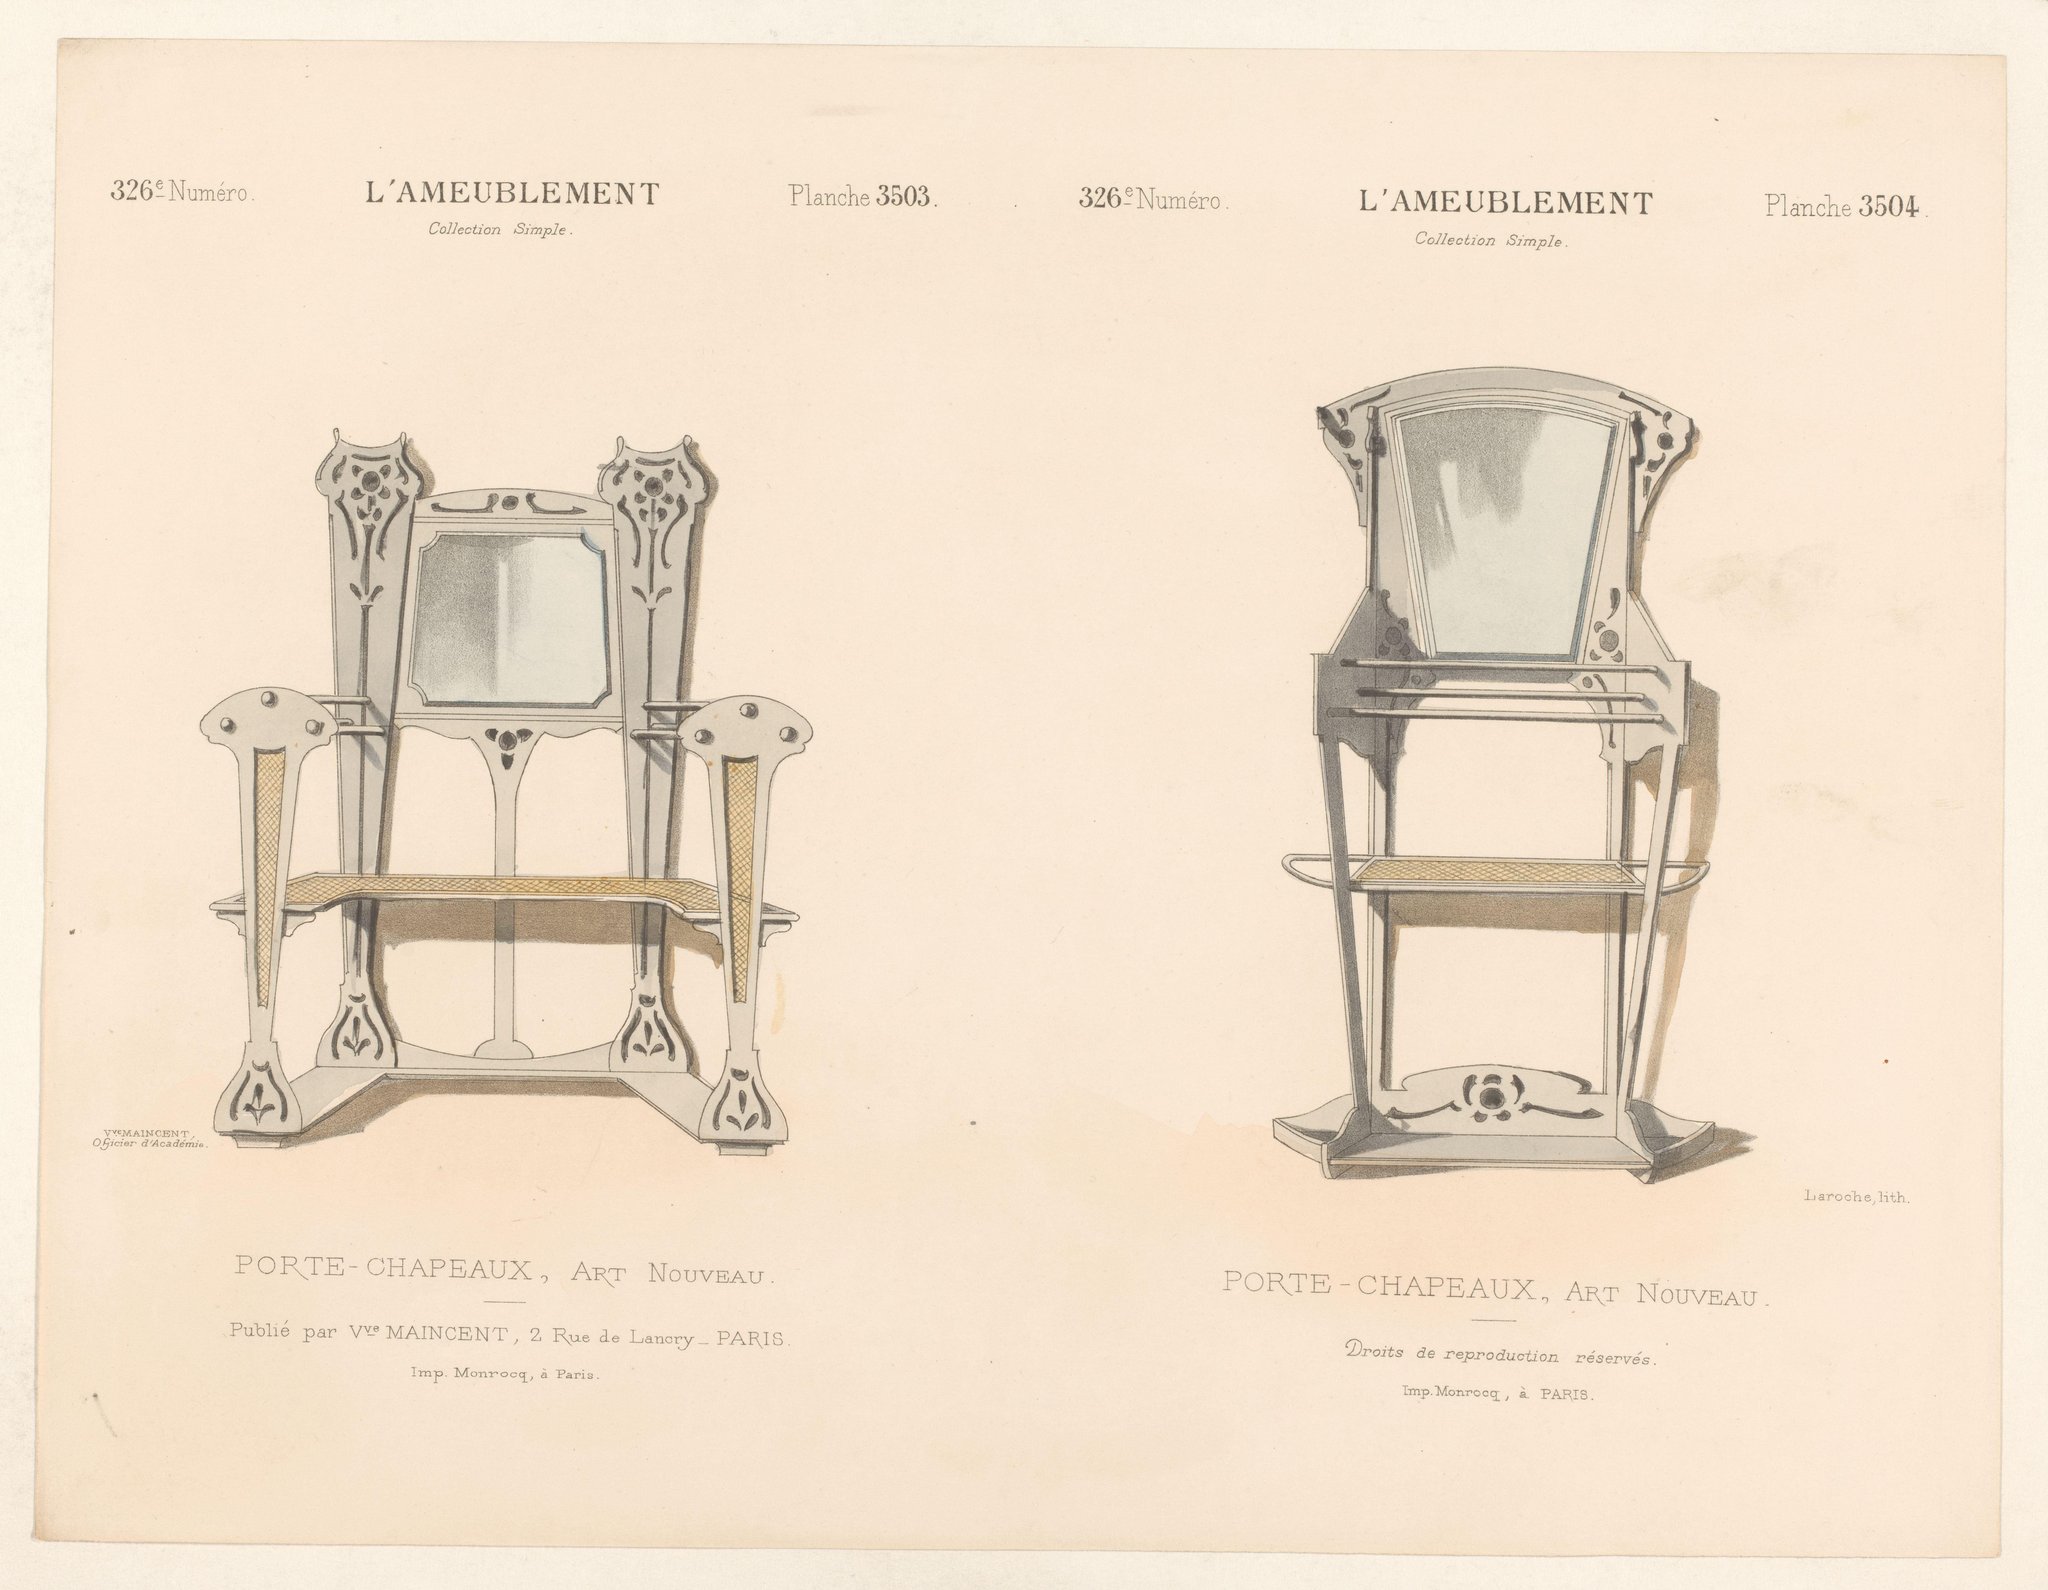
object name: print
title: Twee kapstokken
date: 1895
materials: paper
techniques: hand coloring, lithograph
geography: paris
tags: mirror, hanging clothes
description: Twee kapstokken met spiegel in de art nouveaustijl. Prent uit 326e Livraison.